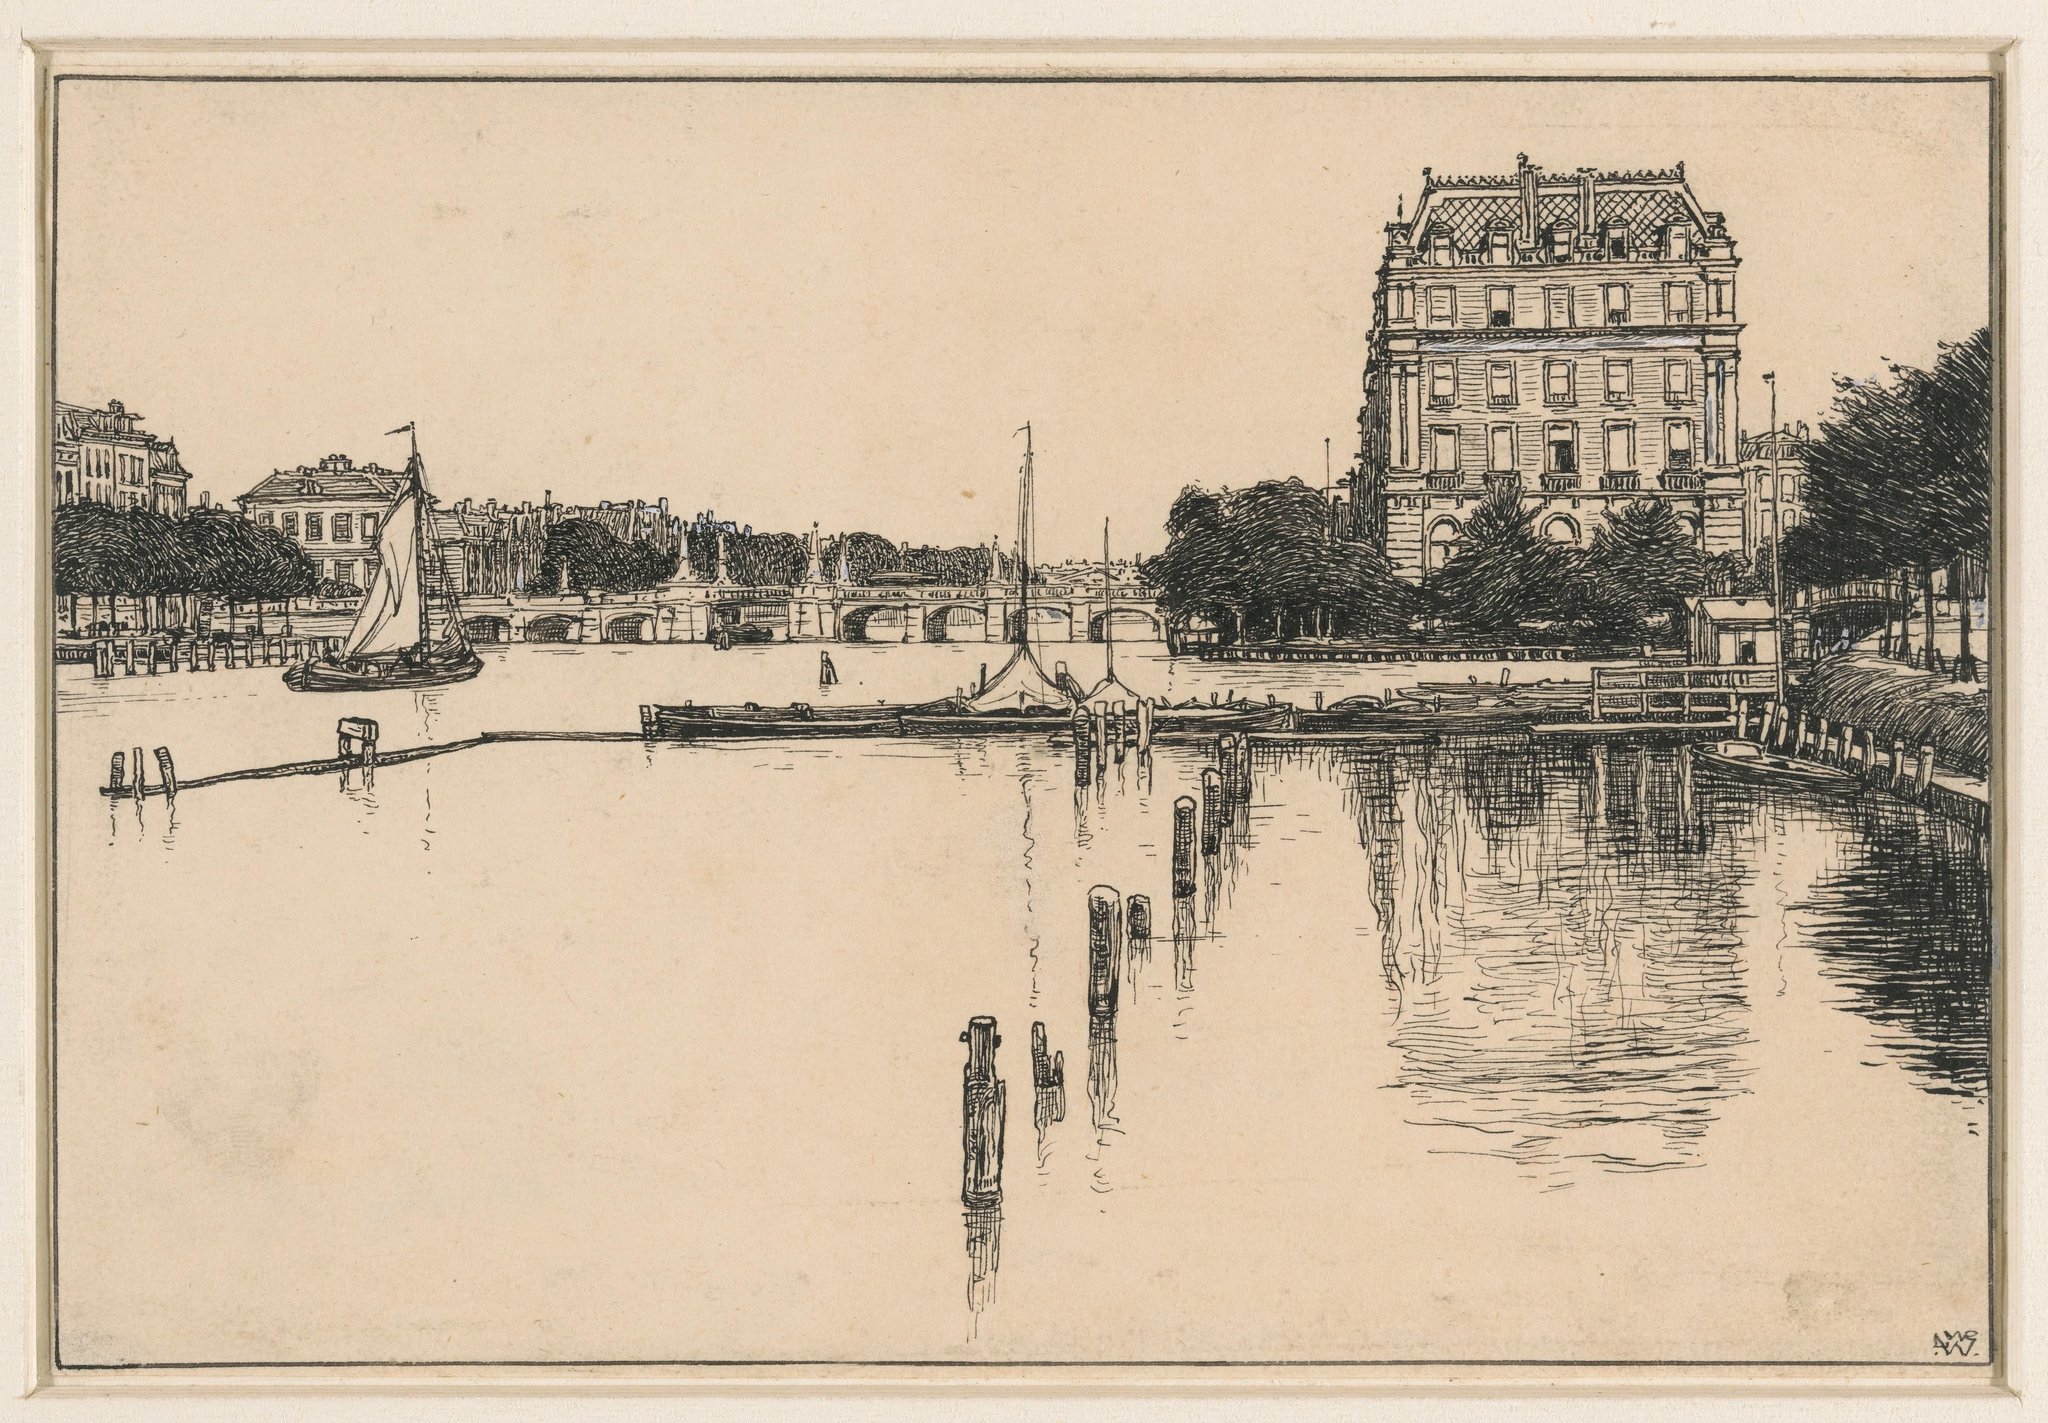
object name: drawing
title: De Amstel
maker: willem wenckebach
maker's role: designer, draughtsman, painter, print maker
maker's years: 1860-1937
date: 1870-1926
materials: paint, ink, paper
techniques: pen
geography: amsterdam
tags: river, amsterdam